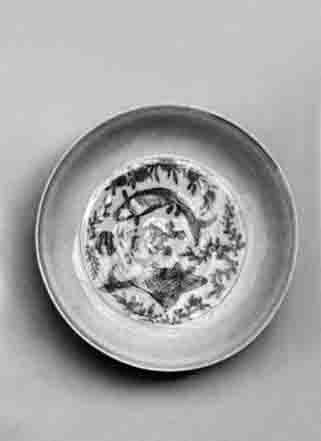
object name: dish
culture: chinese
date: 1573-1620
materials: porcelain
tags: fish